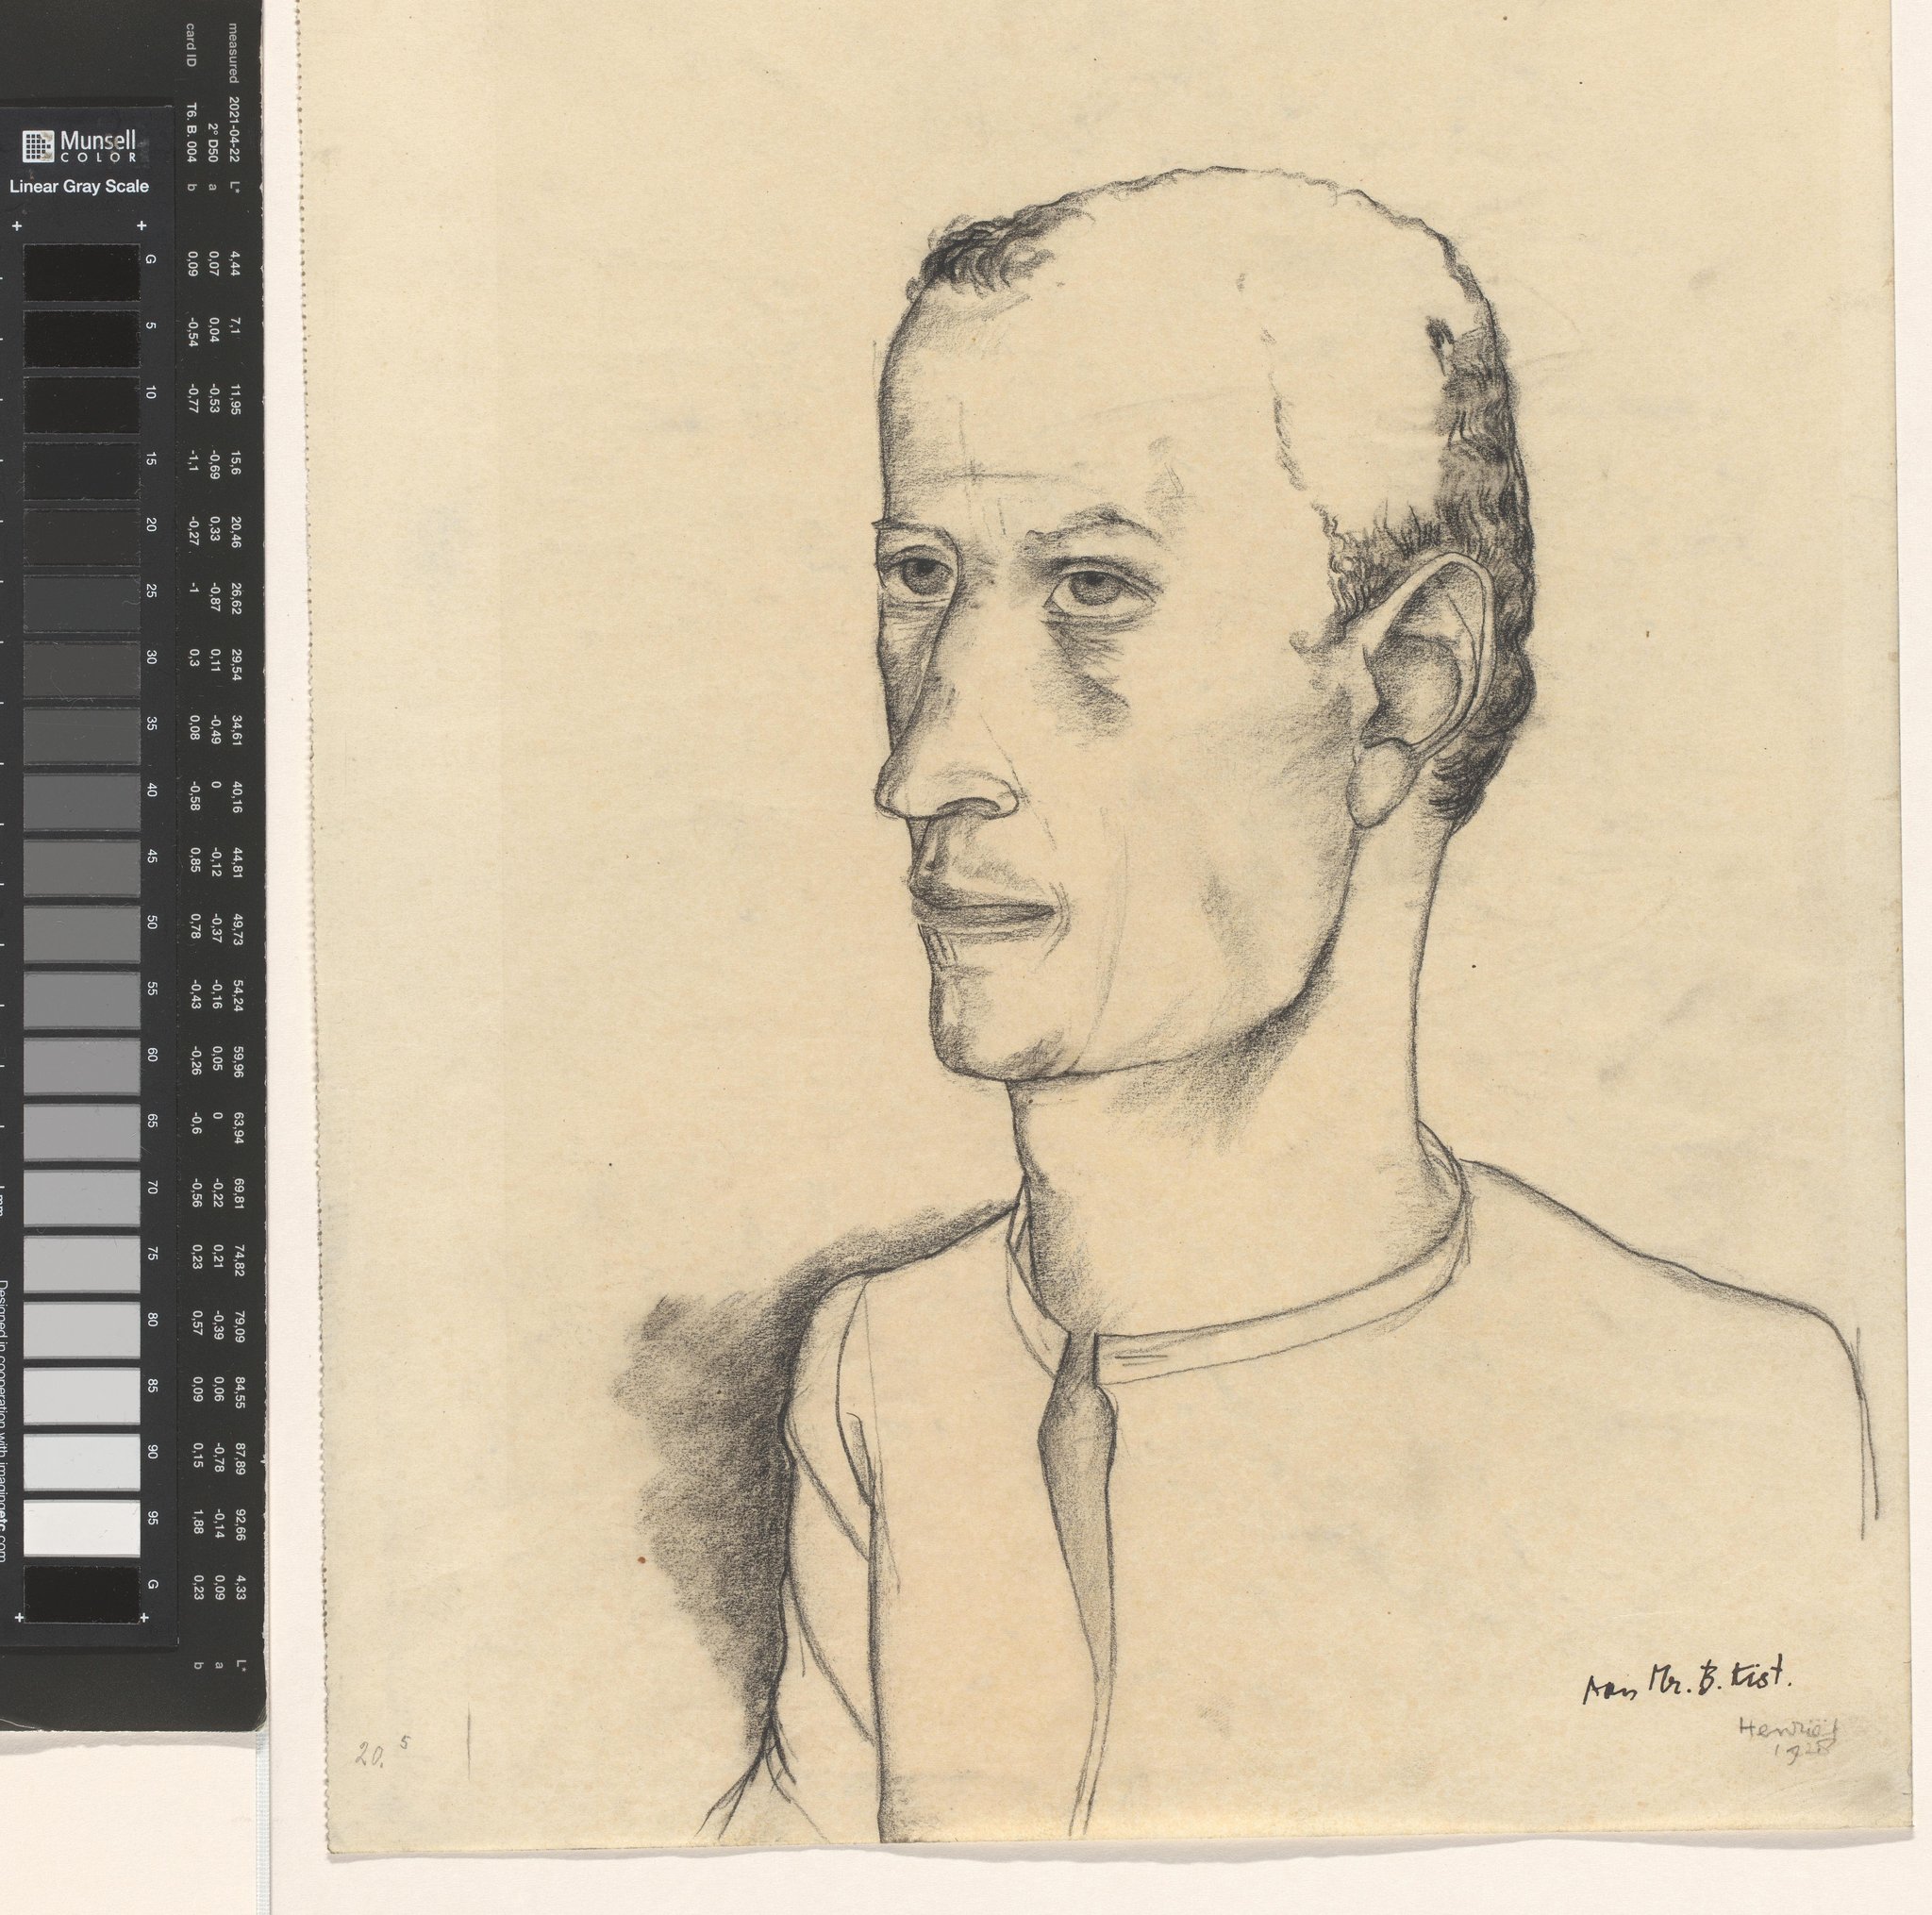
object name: drawing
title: Boerenkop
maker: henk henriët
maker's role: draughtsman, print maker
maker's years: 1903-1945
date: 1928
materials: chalk, paper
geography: amsterdam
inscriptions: inscription: ‘Aan Mr. B. Kist.’, signature and date: ‘Henriët / 1928’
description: Titel zoals die wordt gegeven in: Th. de Vries en J.Q. van Regteren Altena, Henriët (1946), pl. 25